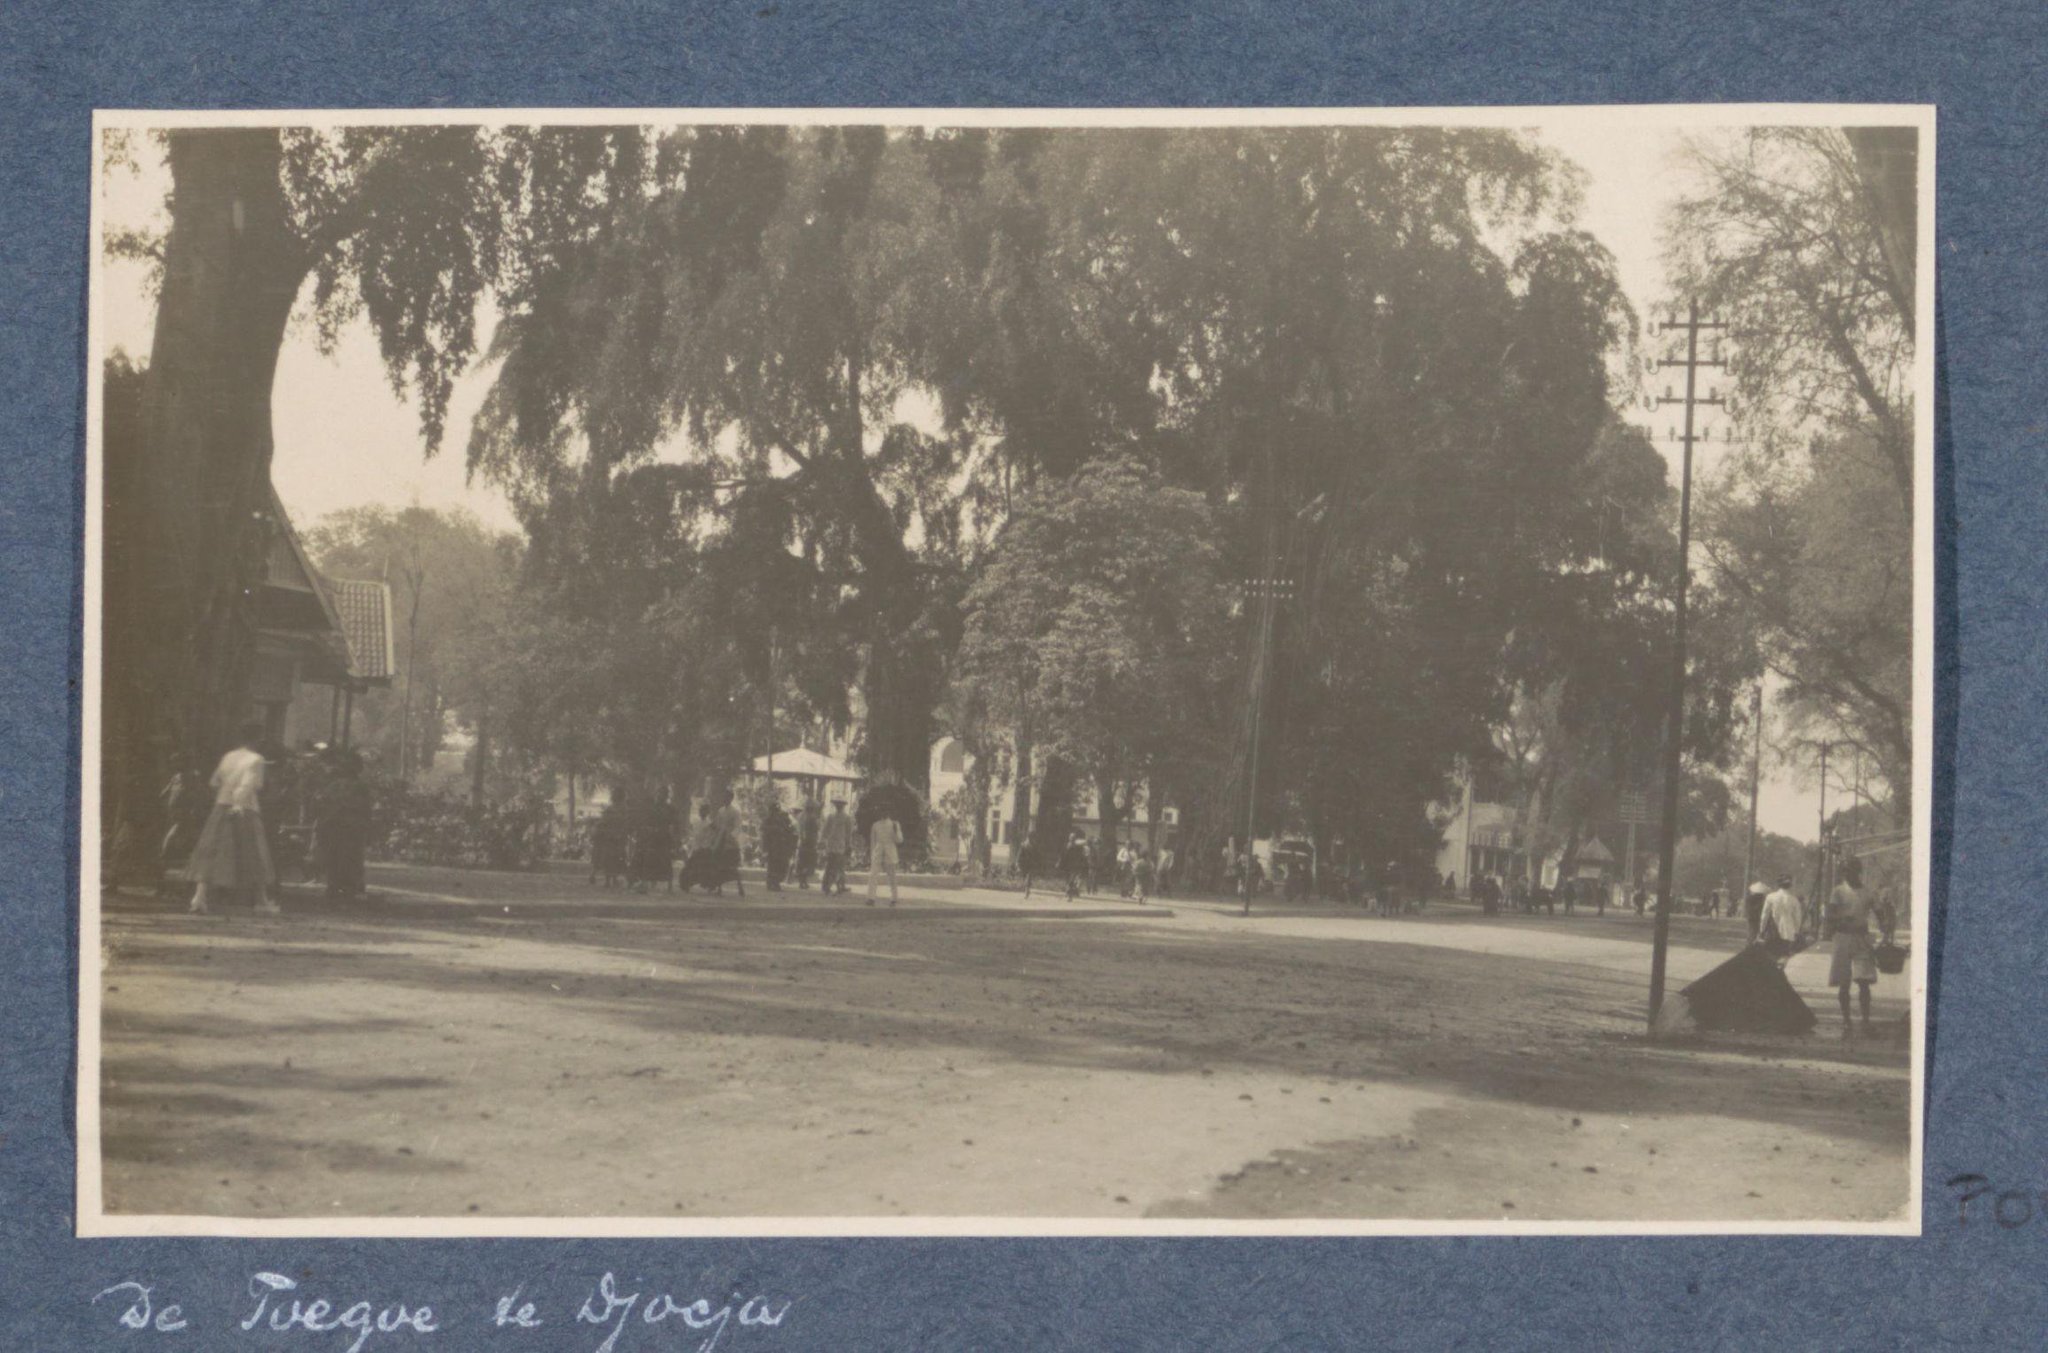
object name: album leaf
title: Vrouw bij het Waterpaleis te Jogyakarta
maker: Anonymous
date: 1900-1920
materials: paper, photographic support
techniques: gelatin silver print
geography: jogjakarta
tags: palace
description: Onderdeel van reisalbum met foto's van bedrijvigheid en bezienswaardigheden op Sumatra en Java en van de reis naar en van Nederlands-Indië.